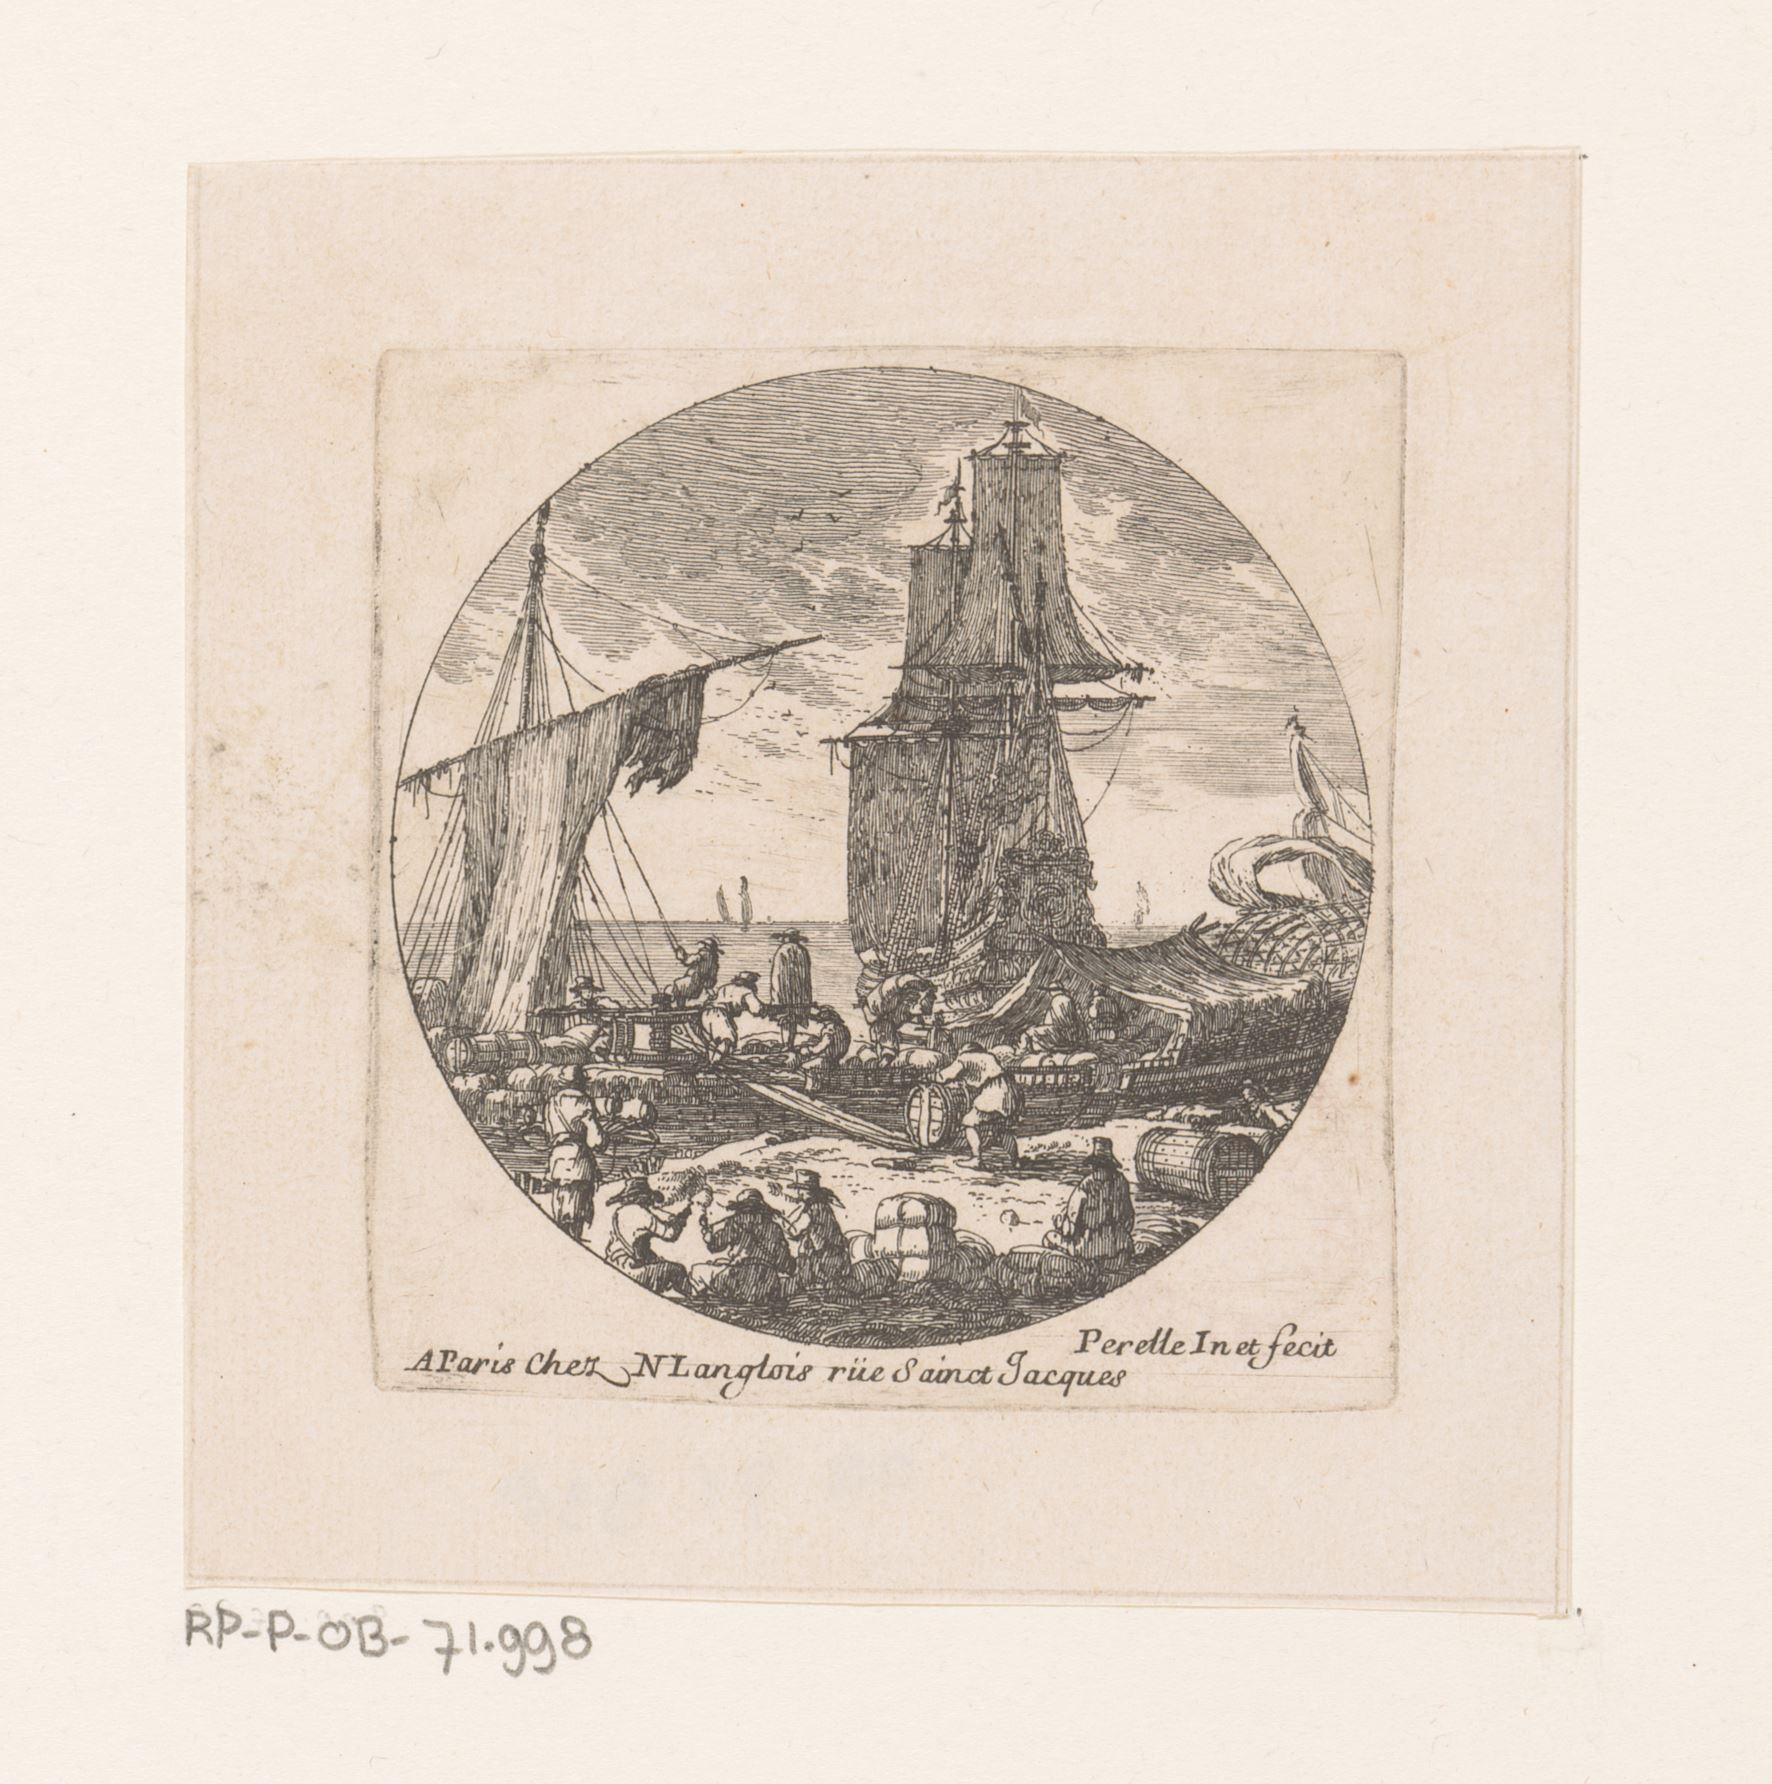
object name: print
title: Bedrijvigheid op kade bij schepen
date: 1650-1695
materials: paper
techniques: etching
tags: harbour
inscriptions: collector's mark: Lugt 240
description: Prenten met het signatuur 'Perelle' kunnen zowel door vader Gabriel als door zonen Nicolas en Adam gemaakt zijn.